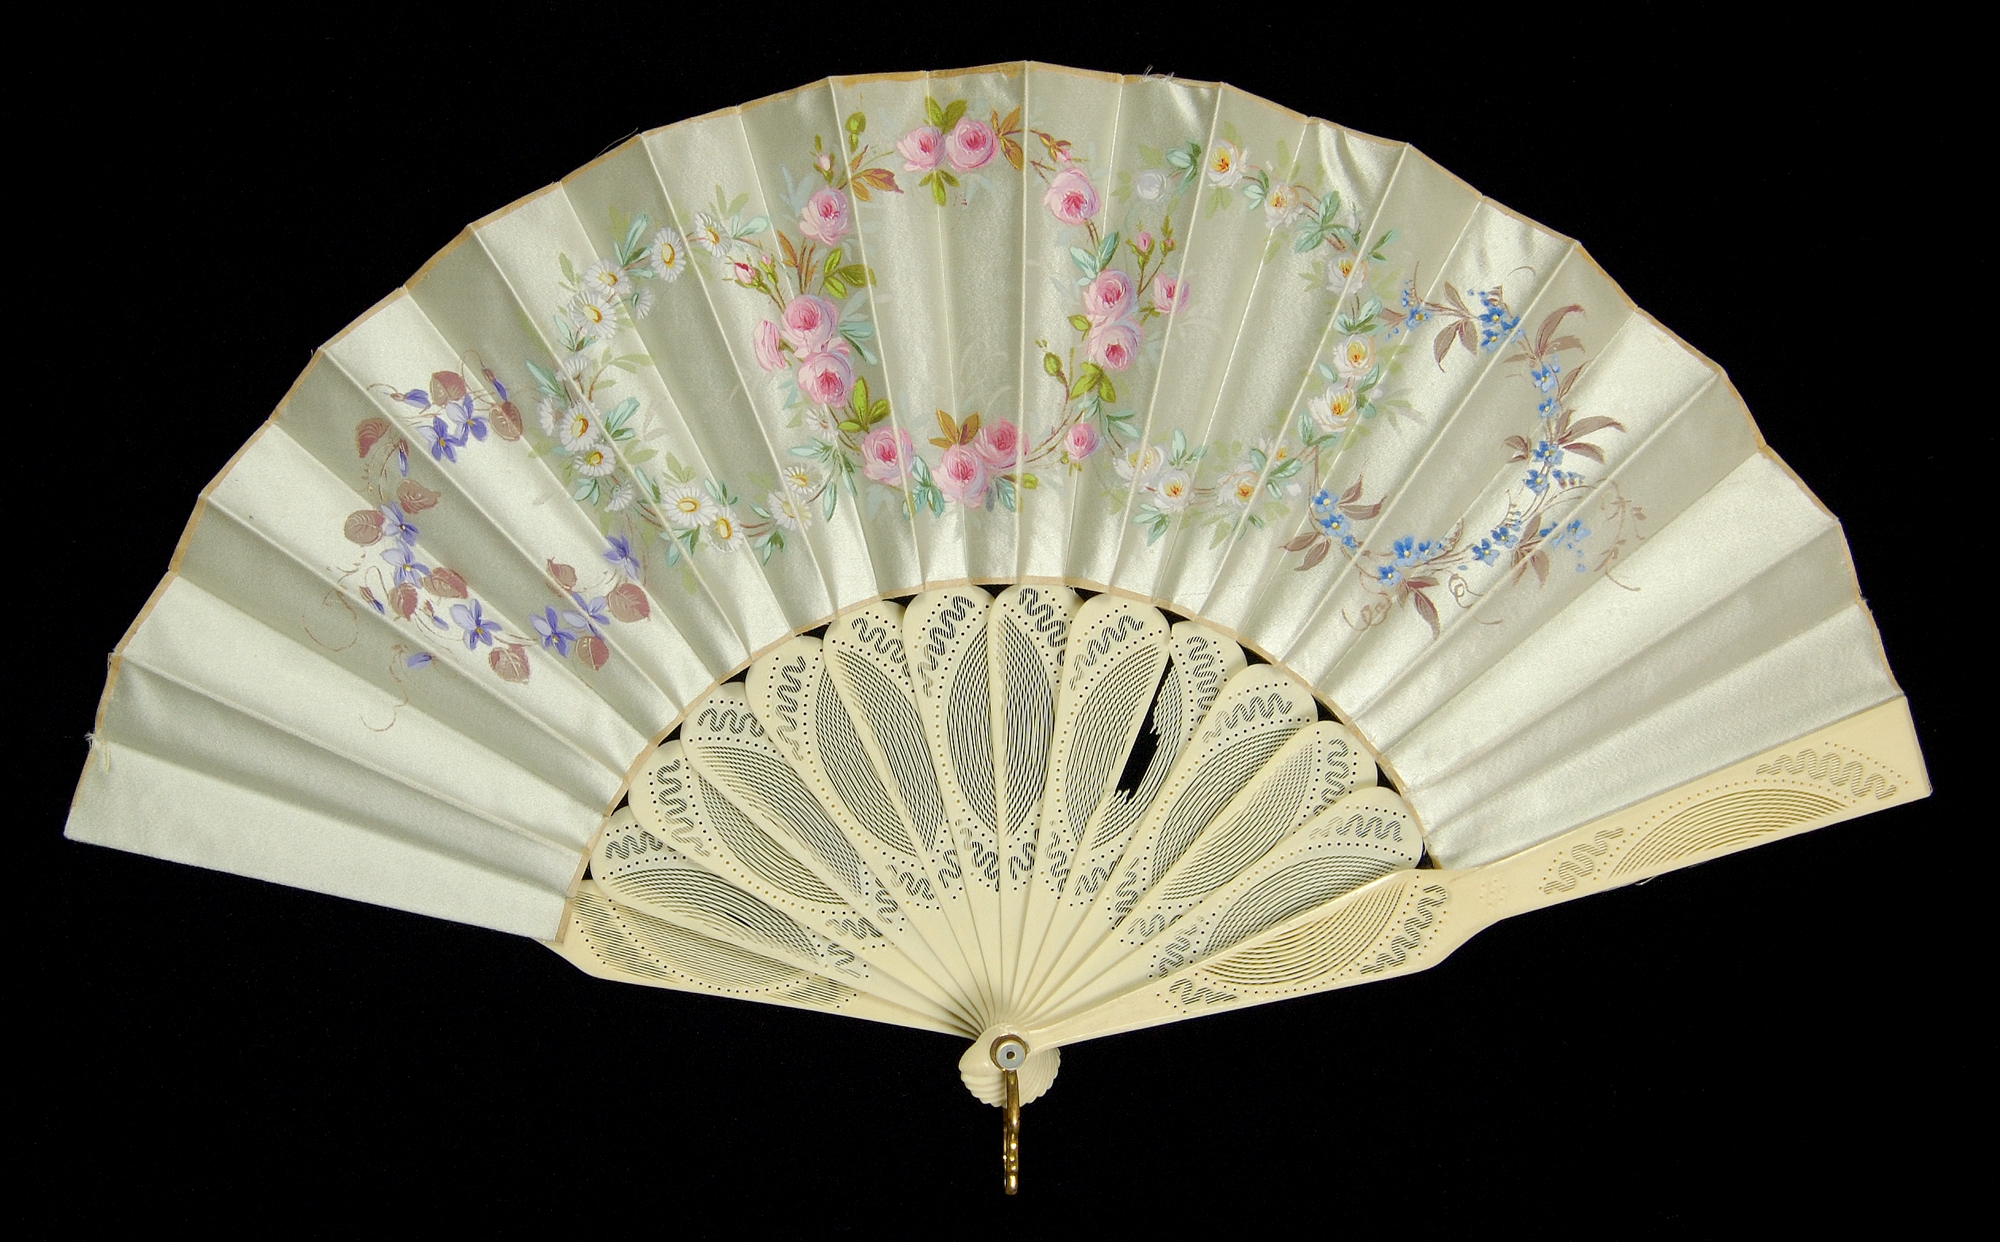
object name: fan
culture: american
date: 1880-1889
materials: ivory, metal, mother of pearl, silk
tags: flowers,roses